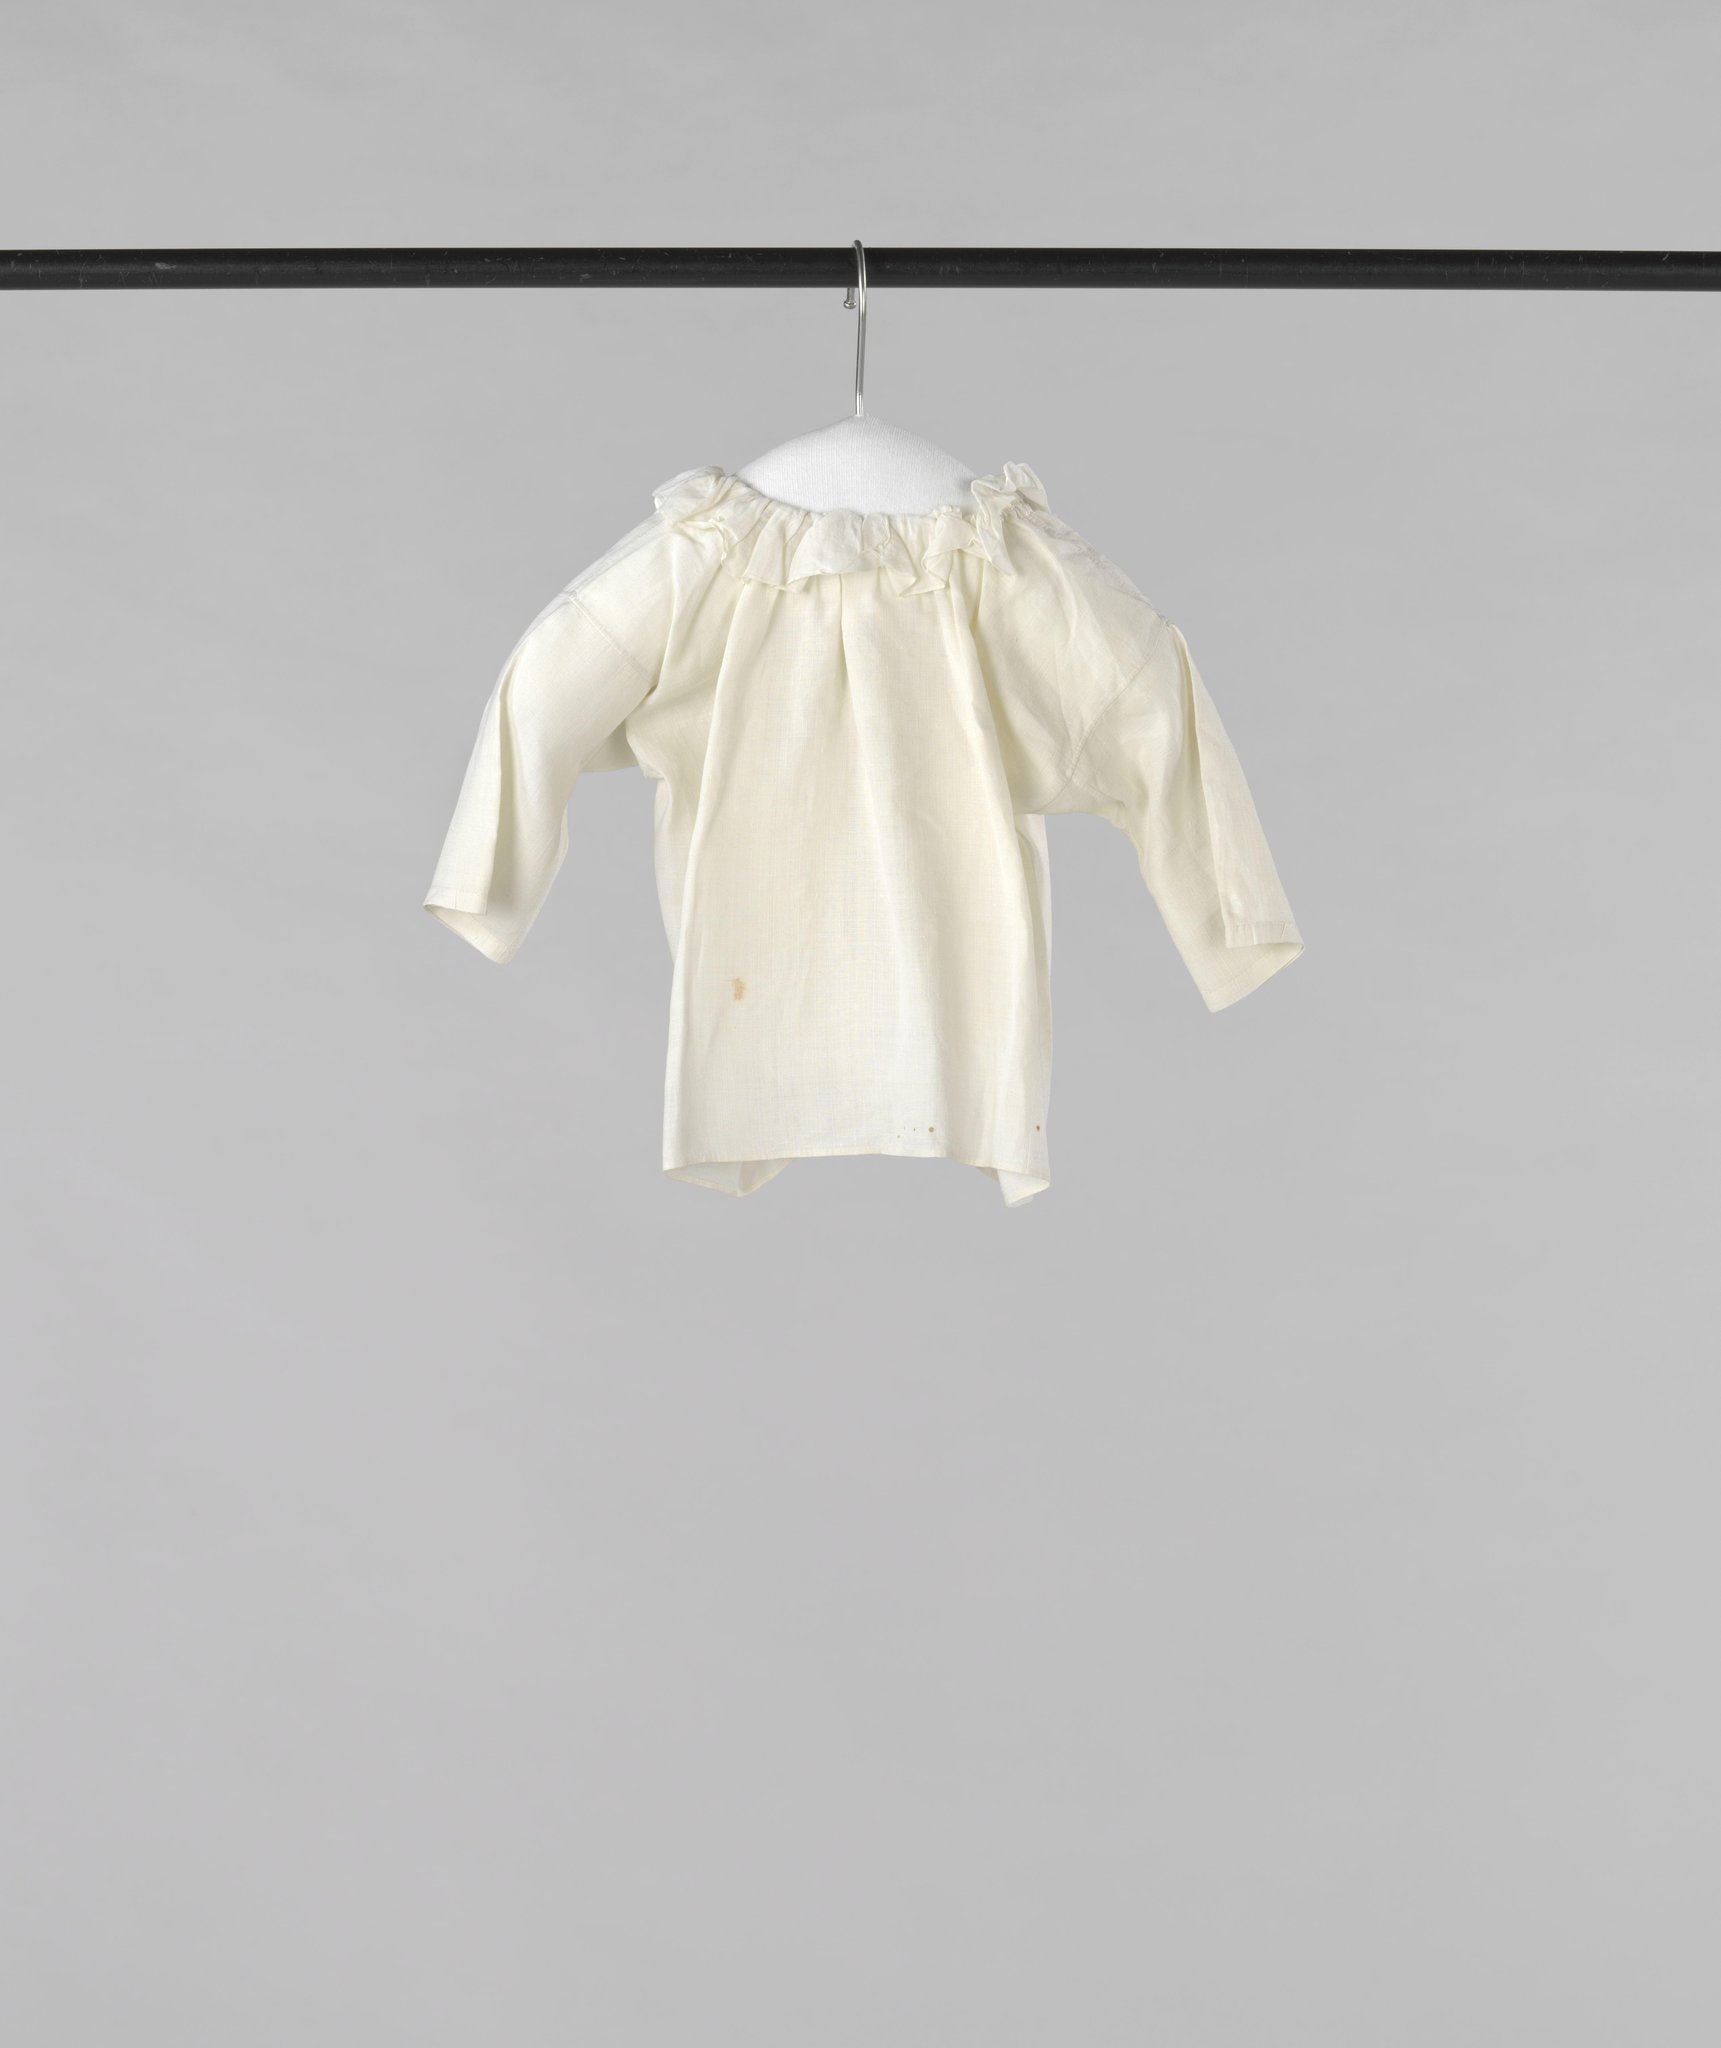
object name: childrenswear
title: Hemd van linnen met kraag van batist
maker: Anonymous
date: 1700-1800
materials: linen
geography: netherlands